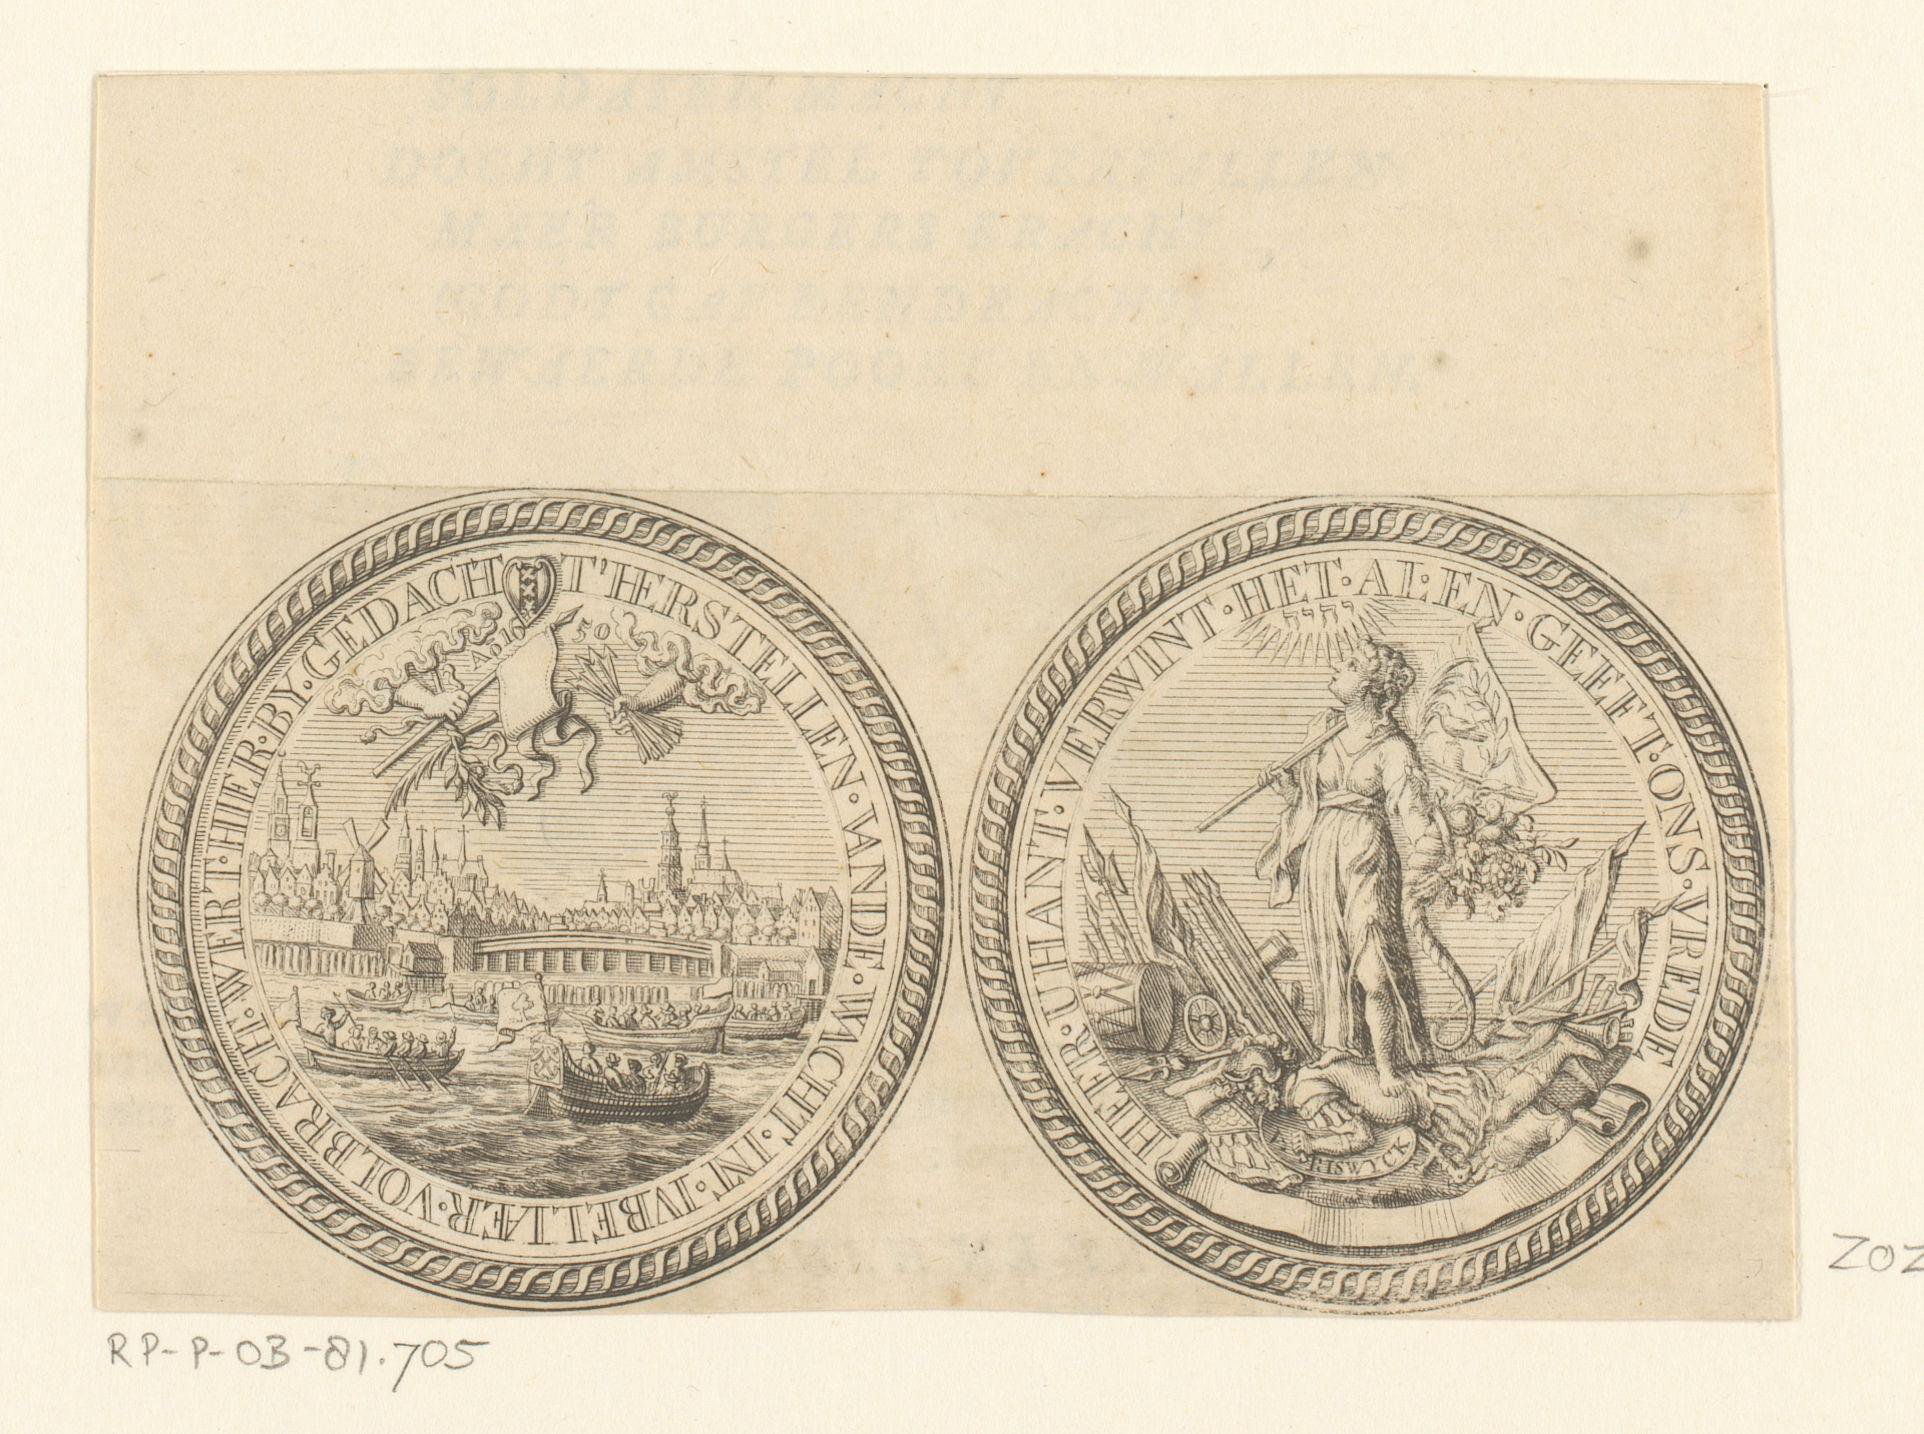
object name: historical object representation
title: Twee penningen op het beleg van Amsterdam door Willem II, 1650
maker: Anonymous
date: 1724-1726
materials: paper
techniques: etching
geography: northern netherlands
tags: william ii (prince of orange), medal (considered as a piece of sculpture, regardless of its specific function), amsterdam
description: Twee penning over de gebeurtenissen te Amsterdam in het jaar 1650, op de voor- en achterzijde van een blad. Penning op voorkant: voorzijde: boten met soldaten op de Amstel, uit de wolken steken handen met pijlenbundel, vaandel en palmtak. Keerzijde: de Vrede staande met vaandel op wapens. Penning op achterkant: voorzijde: gezicht op Amsterdam en schepen op de Amstel, daarboven hand uit wolken met hart en wapenschild van de stad met wimpel met opschrift. Keerzijde: het wegvoeren van zes leden van de Staten van Holland naar het slot Loevestein en doodshoofd met duif met palmtak in bek. Uitgeknipte illustratie bedrukt met tekst op achterzijde.